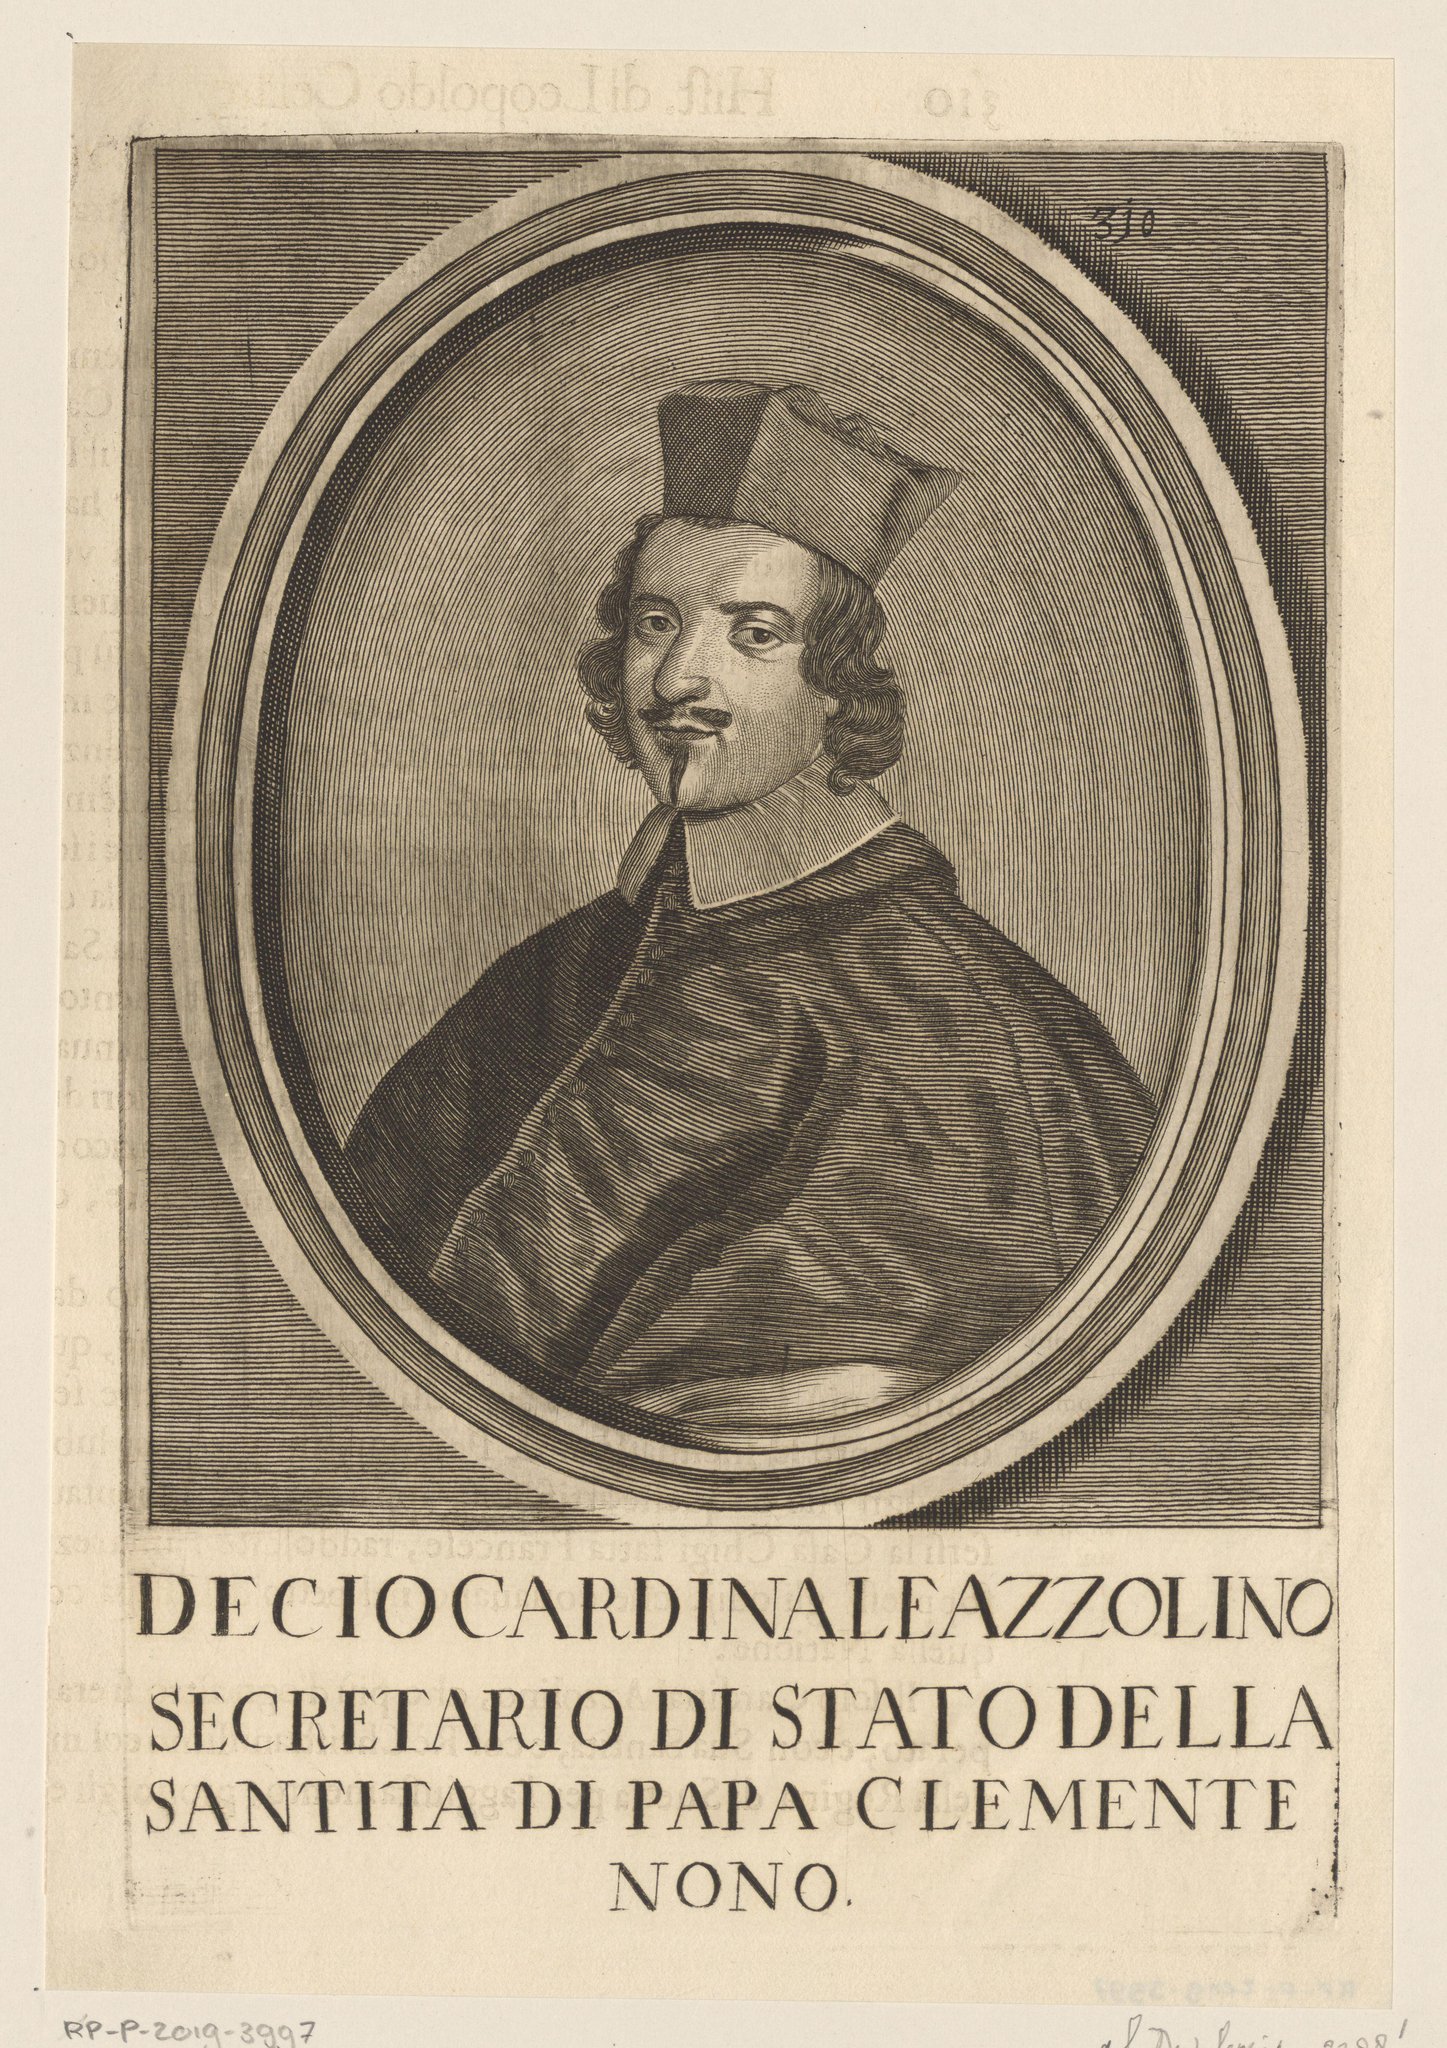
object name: print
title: Portret van kardinaal Decio Azzolini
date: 1670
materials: paper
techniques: etching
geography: vienna state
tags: decio azzolini, historical persons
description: Prent uit: Priorato, Galeazzo Gualdo. Historia di Leopoldo Cesare, (...). Wenen: Giovanni Battista Hacque, 1670, dl. 2, p. 310.